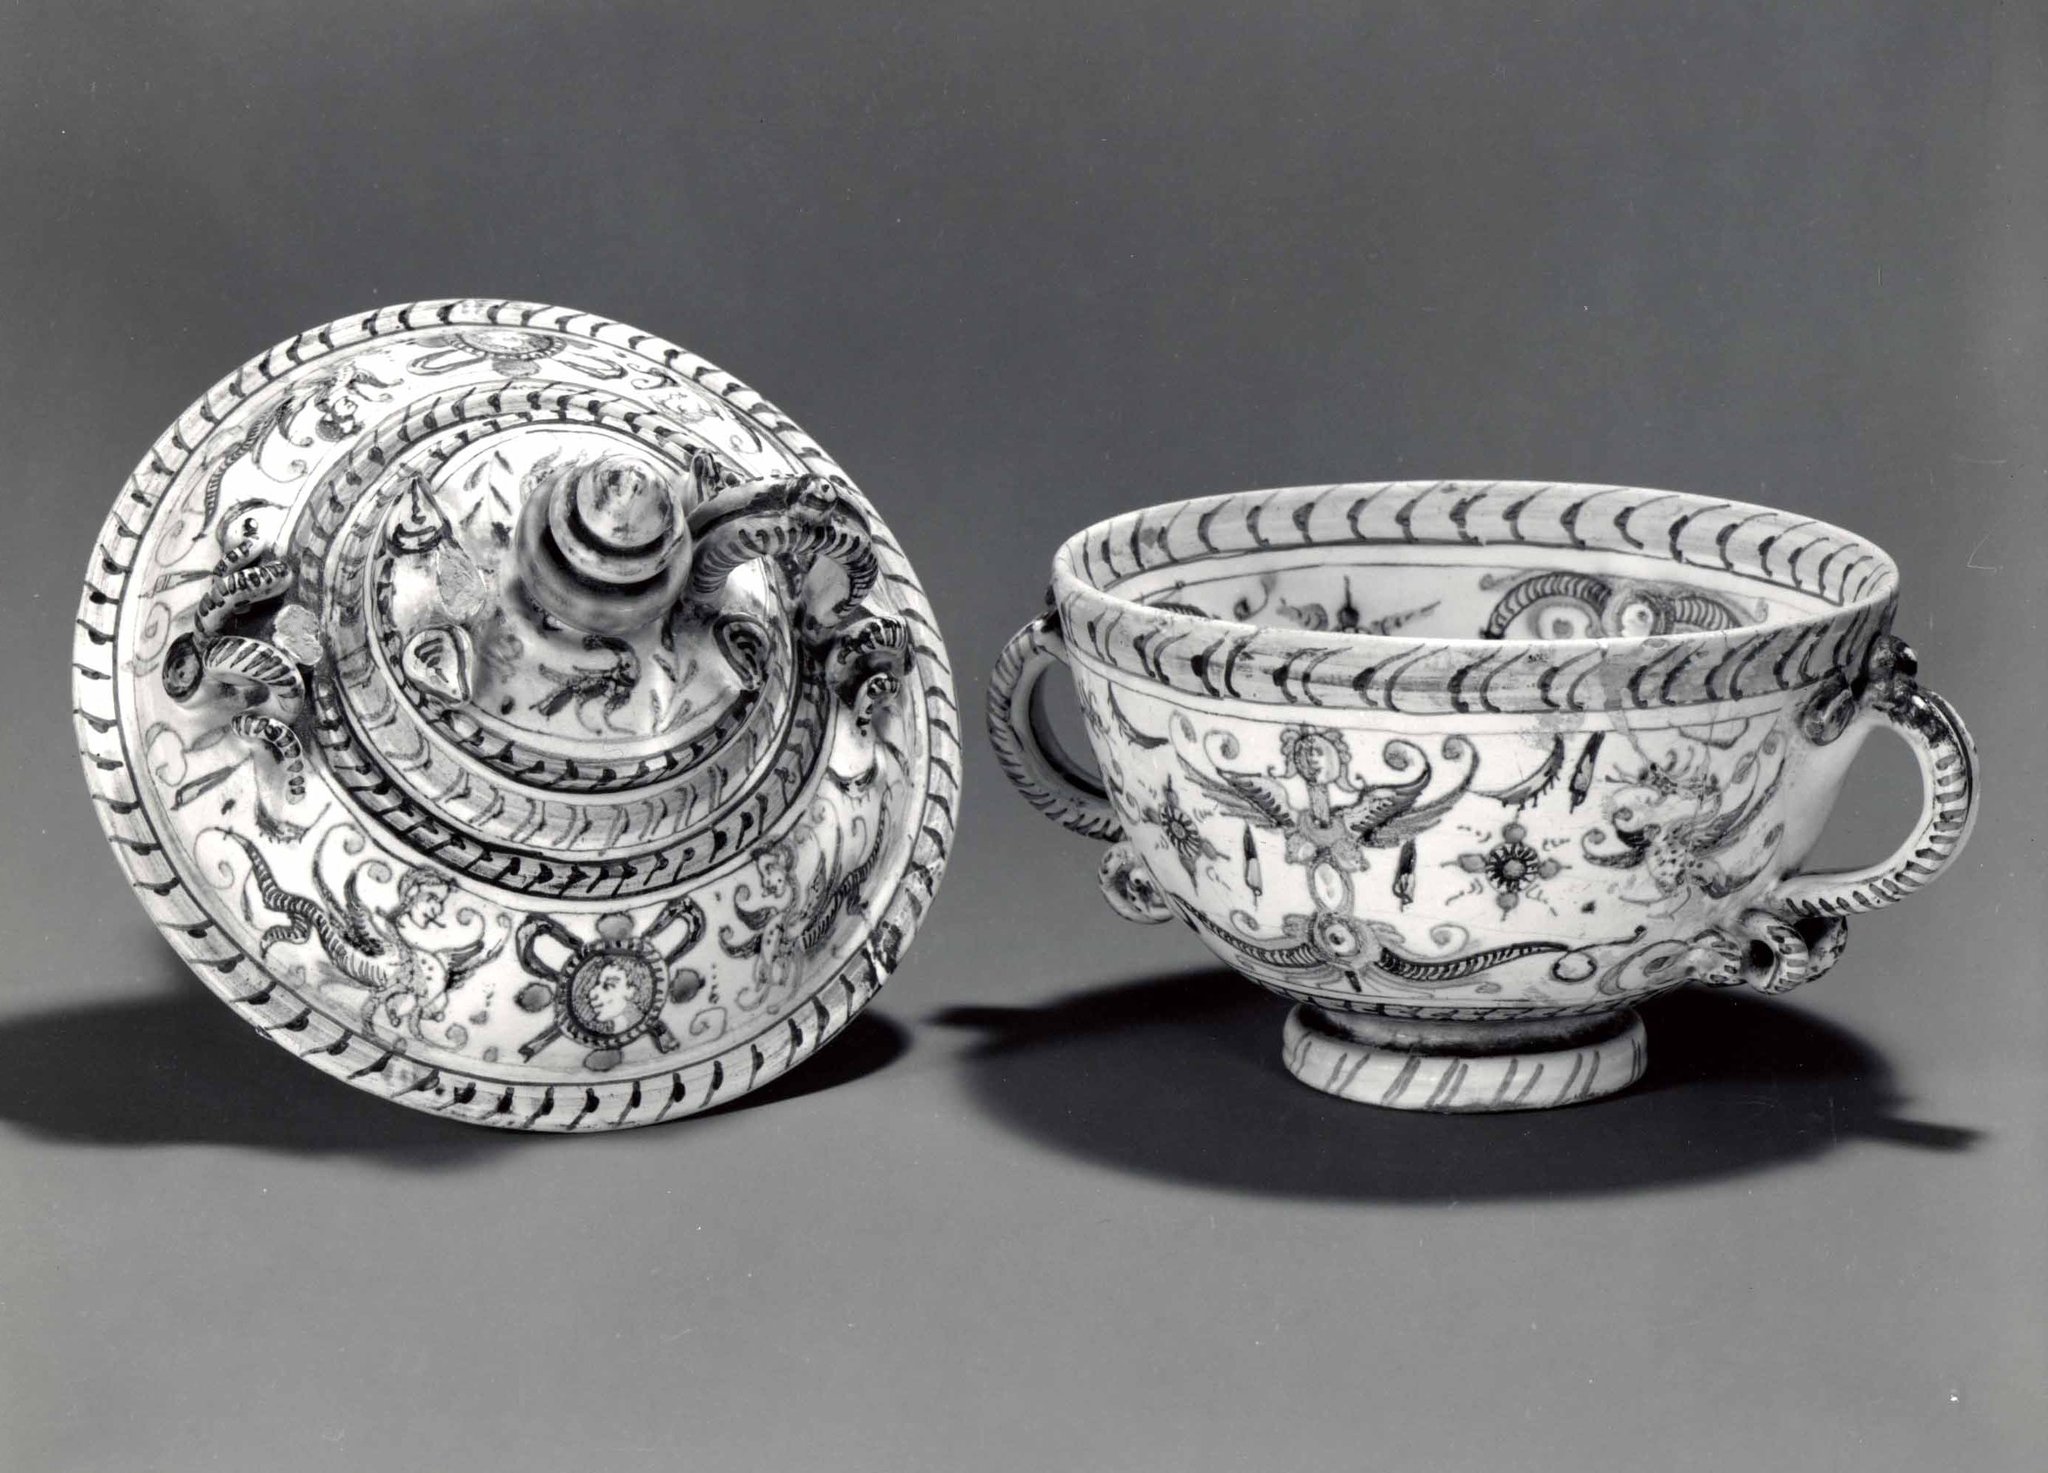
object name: soup bowl with cover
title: Soup bowl with cover (tazza con coperchio)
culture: italian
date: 1601-1633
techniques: maiolica, glazing